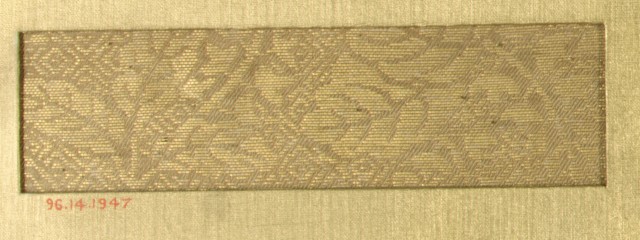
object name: piece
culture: japanese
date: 1701-1900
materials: silk